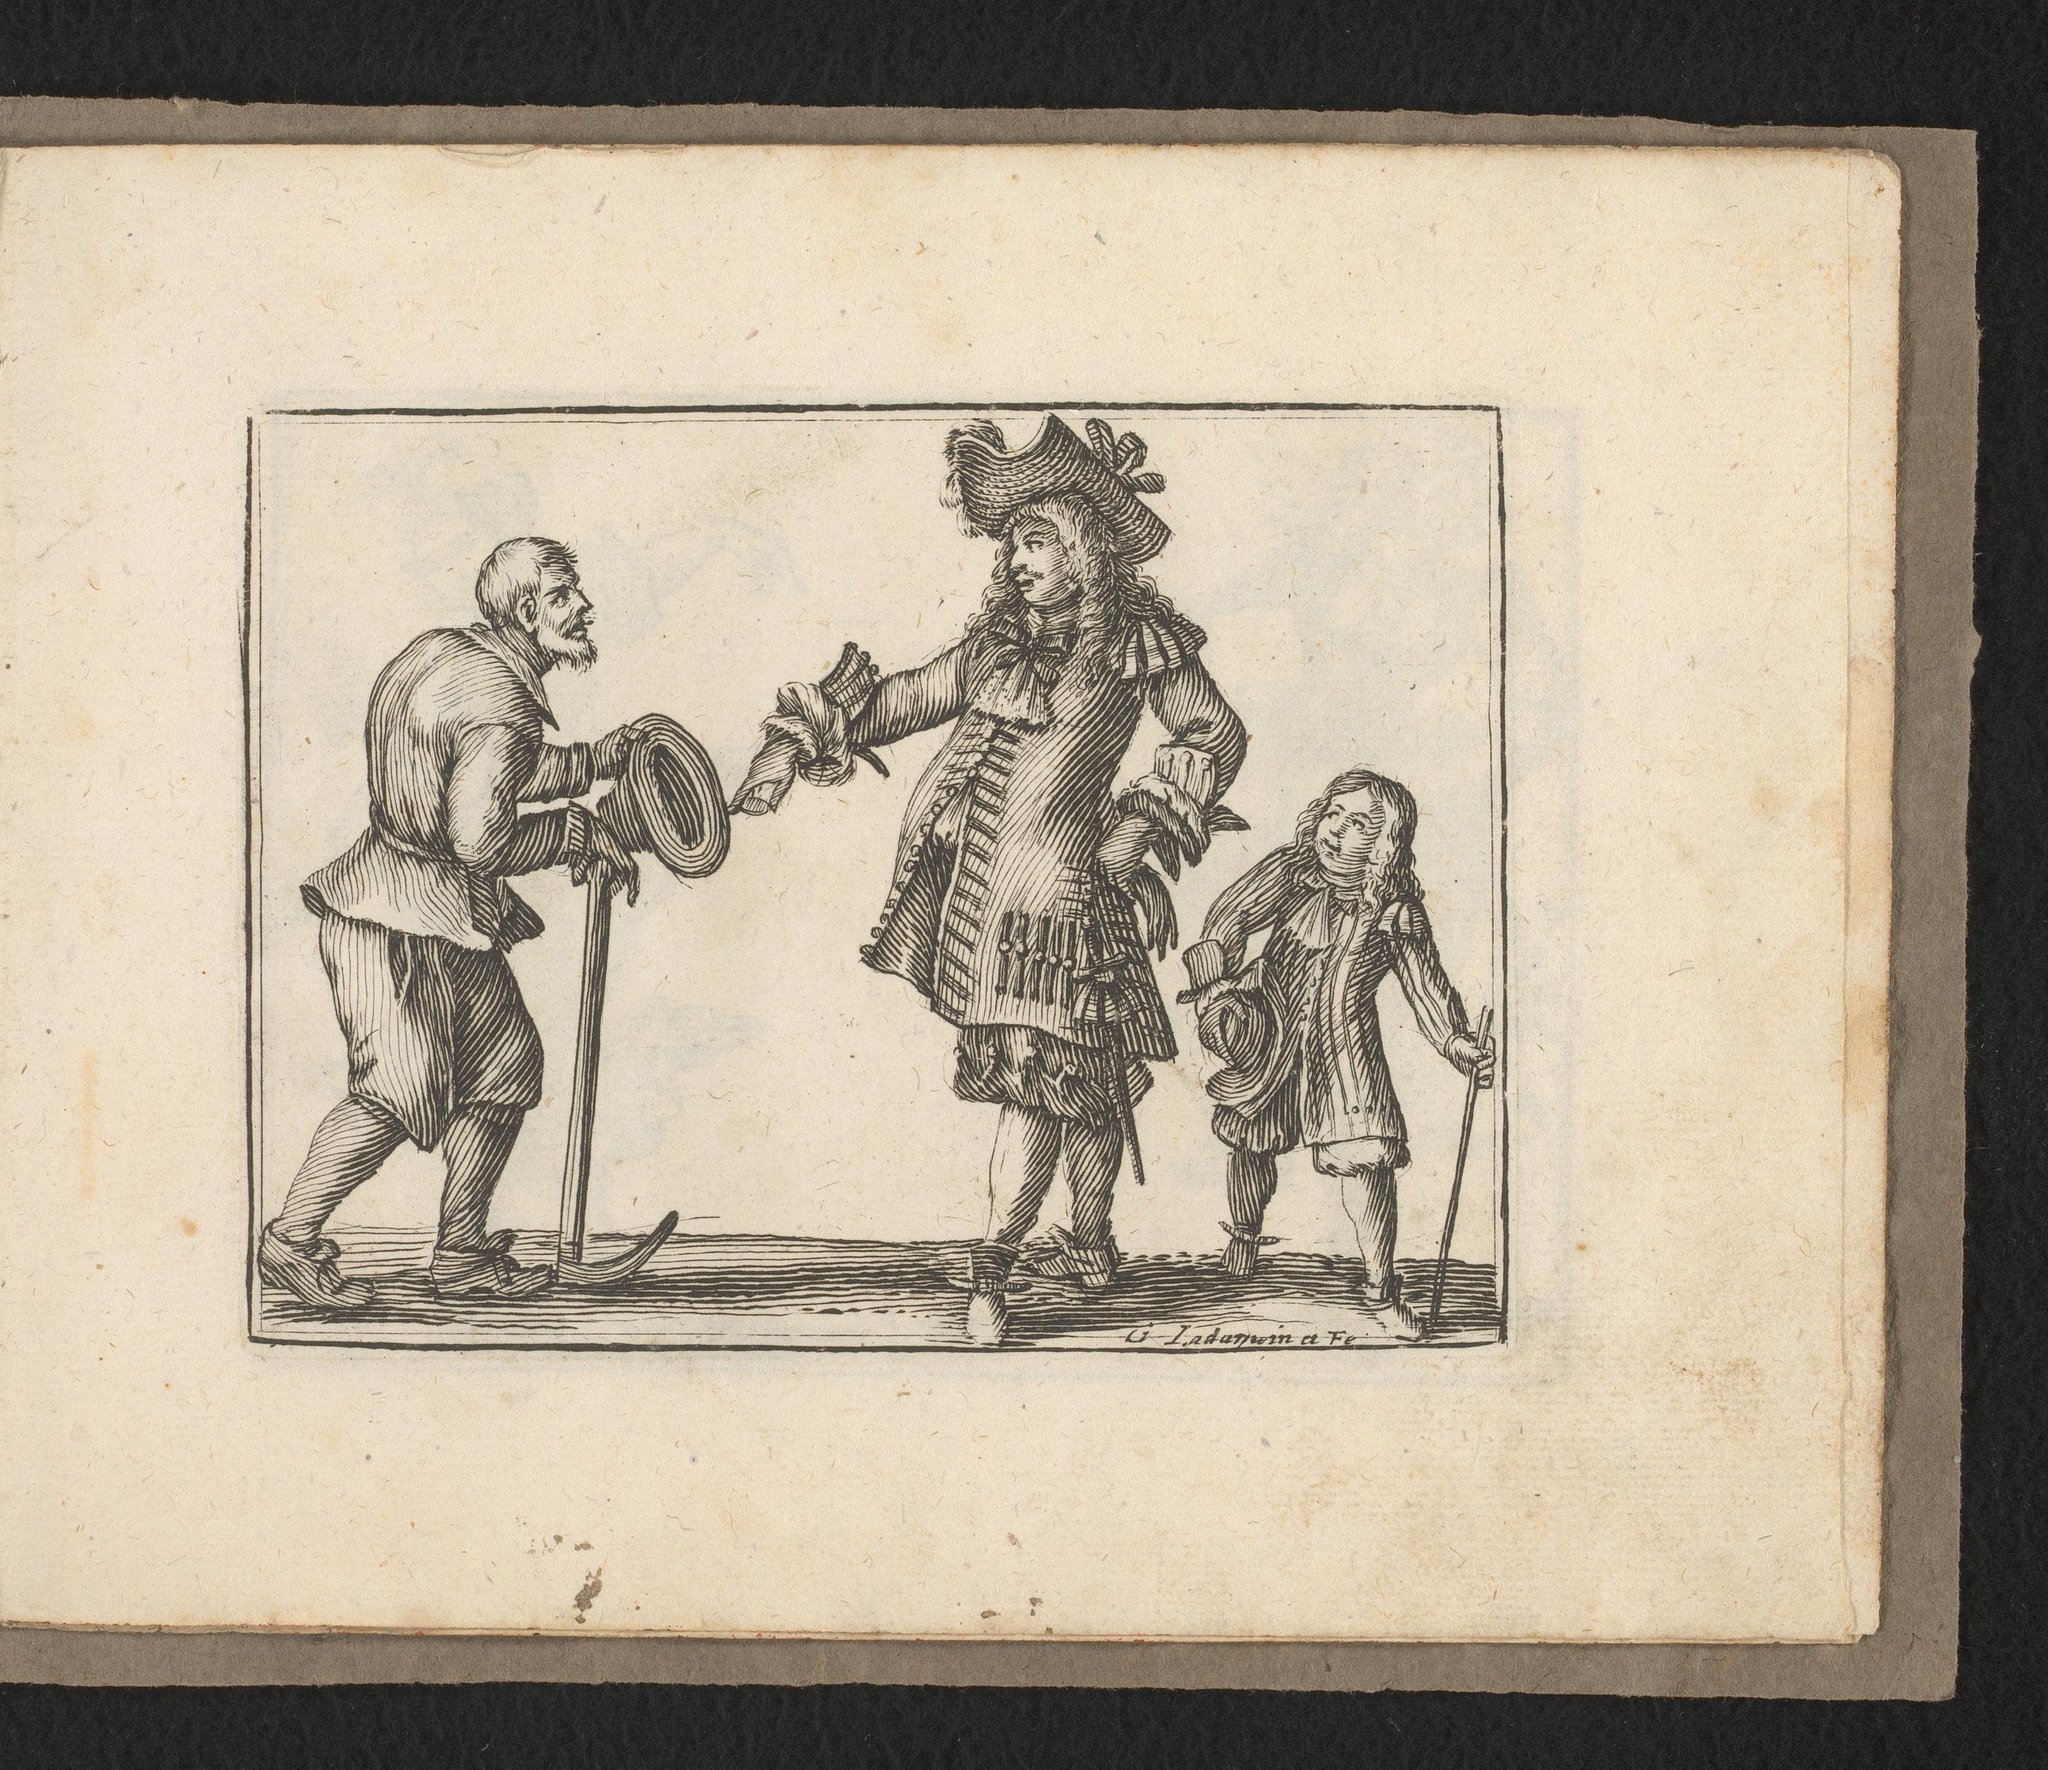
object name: print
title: Rijke man met jongen schenkt een aalmoes aan een bedelaar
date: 1660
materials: paper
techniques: etching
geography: paris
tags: giving alms or other charity, e.g.: handing out food, upper ten, clothes, costume (+ men's clothes), beggar, house personnel, servants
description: Deze prent maakt deel uit van een album.